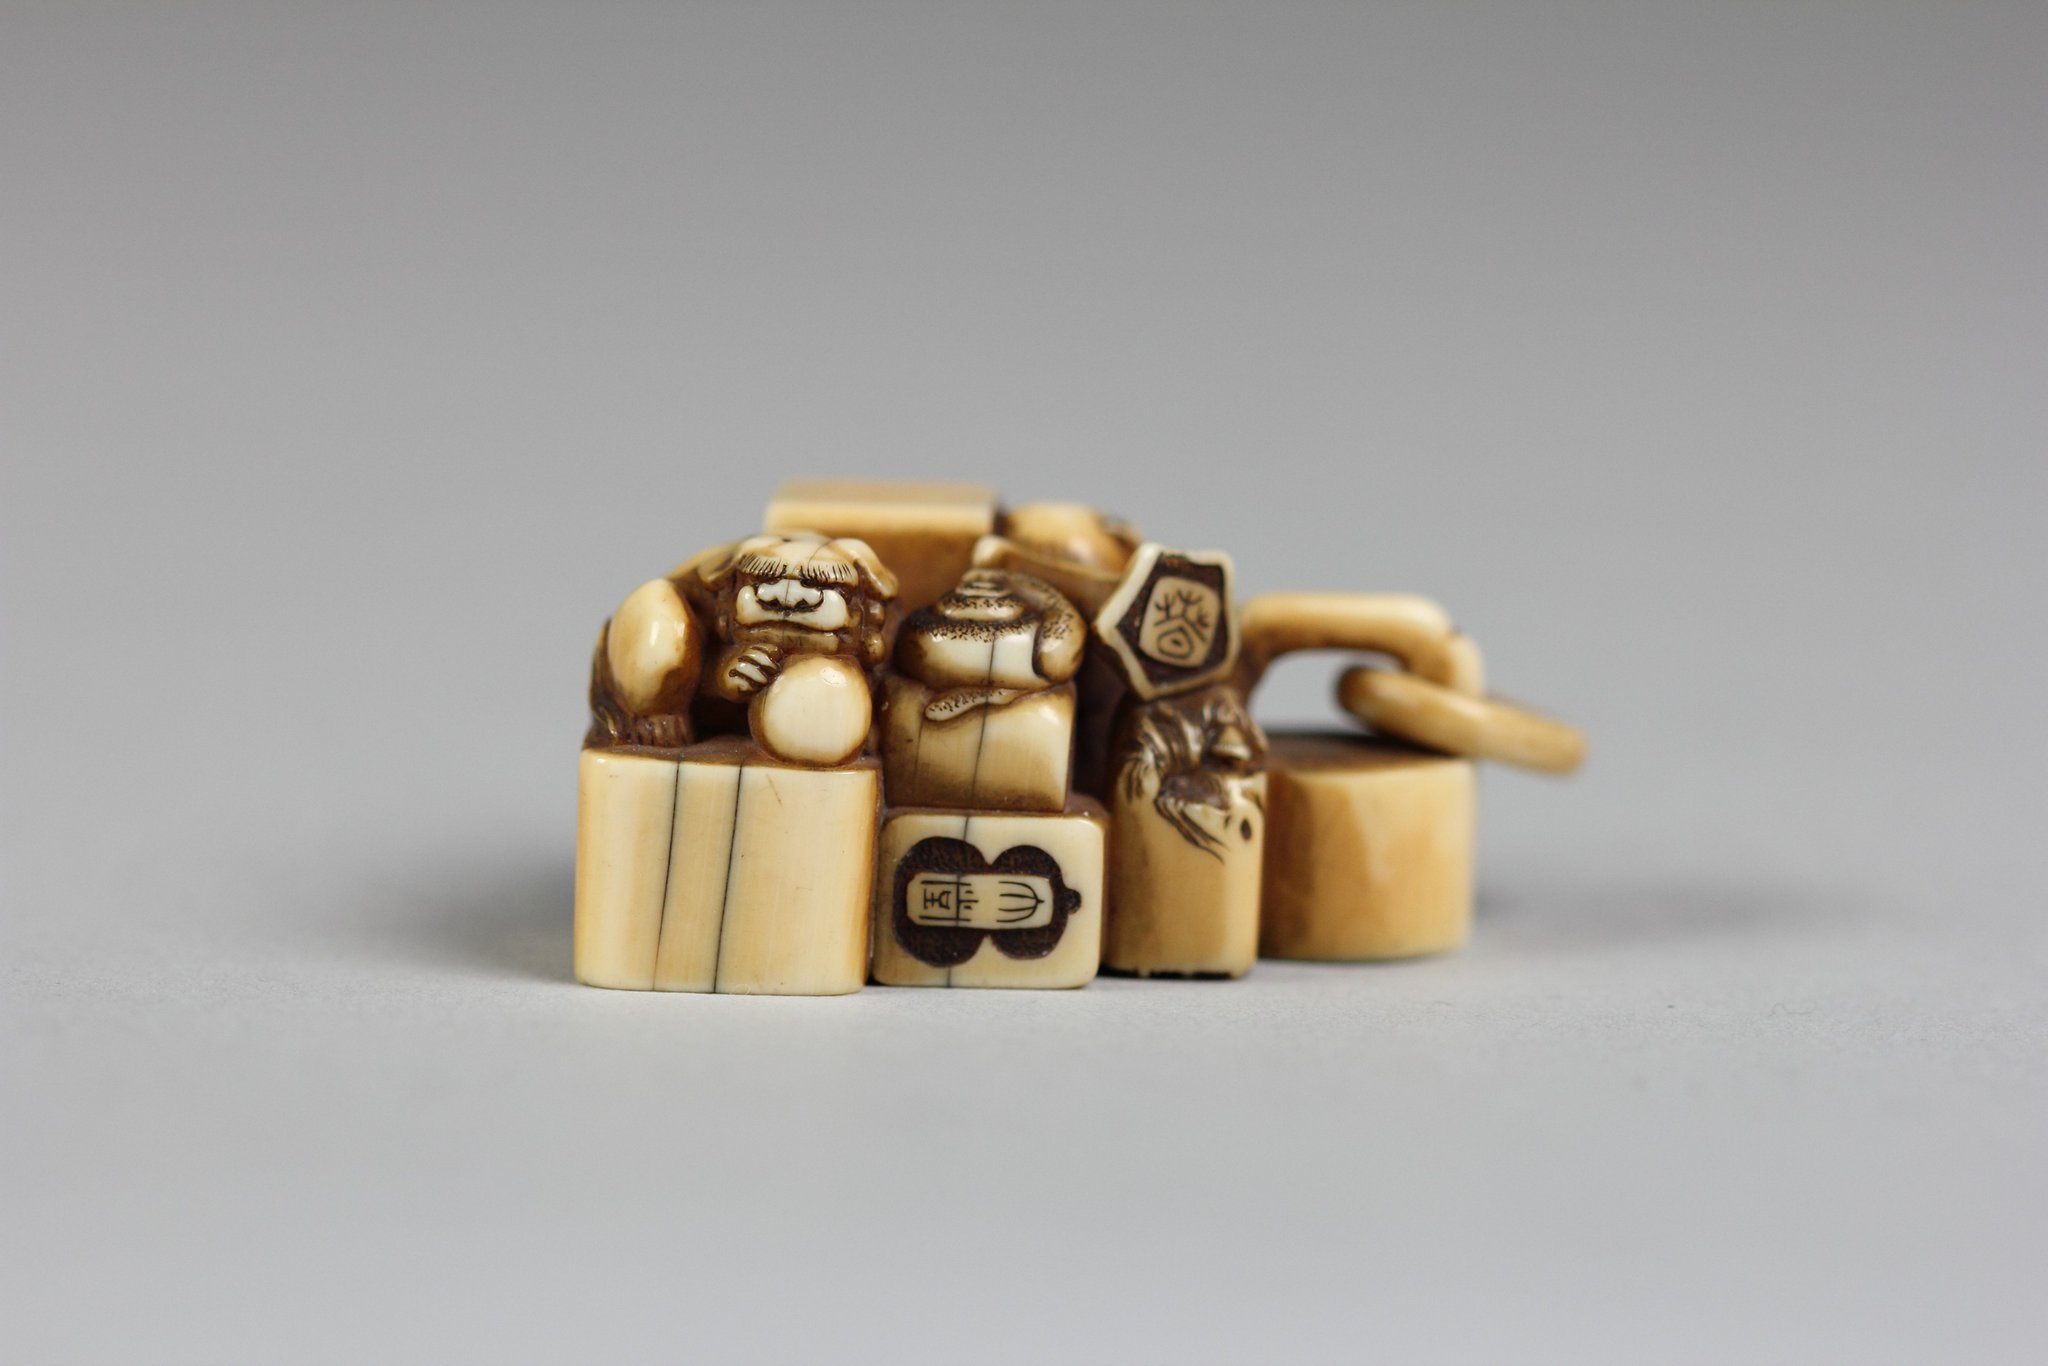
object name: netsuke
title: Netsuke of Group of Eight Seals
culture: japanese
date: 1701-1900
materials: ivory